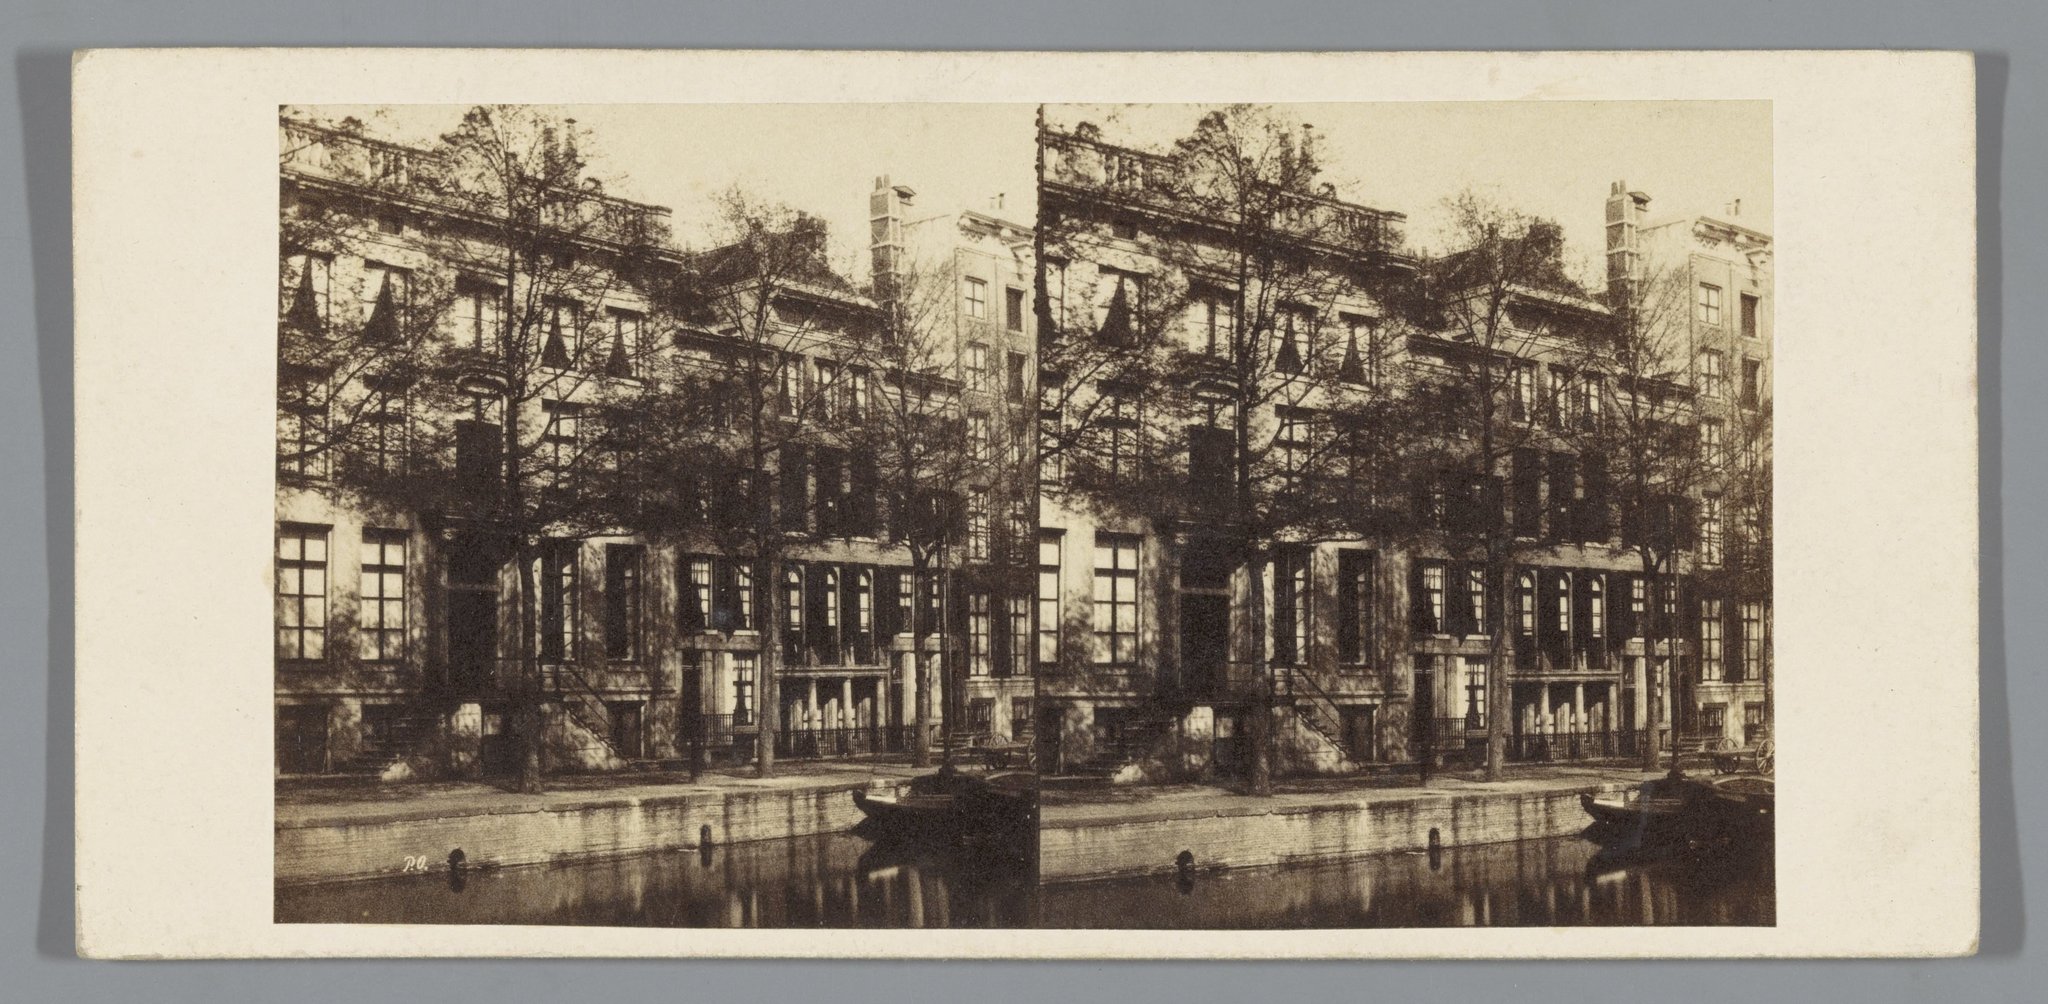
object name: stereograph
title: Amsterdam, Herengracht bij Thorbeckeplein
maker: pieter oosterhuis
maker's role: draughtsman, print maker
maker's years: 1816-1885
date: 1855-1865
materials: cardboard, paper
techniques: albumen print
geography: amsterdam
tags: canals, waters (in city)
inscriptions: initials: ‘P.O.’, inscription: ‘foto Pieter Oosterhuis/ Amsterdam Herengracht bij Thorbeckeplein’